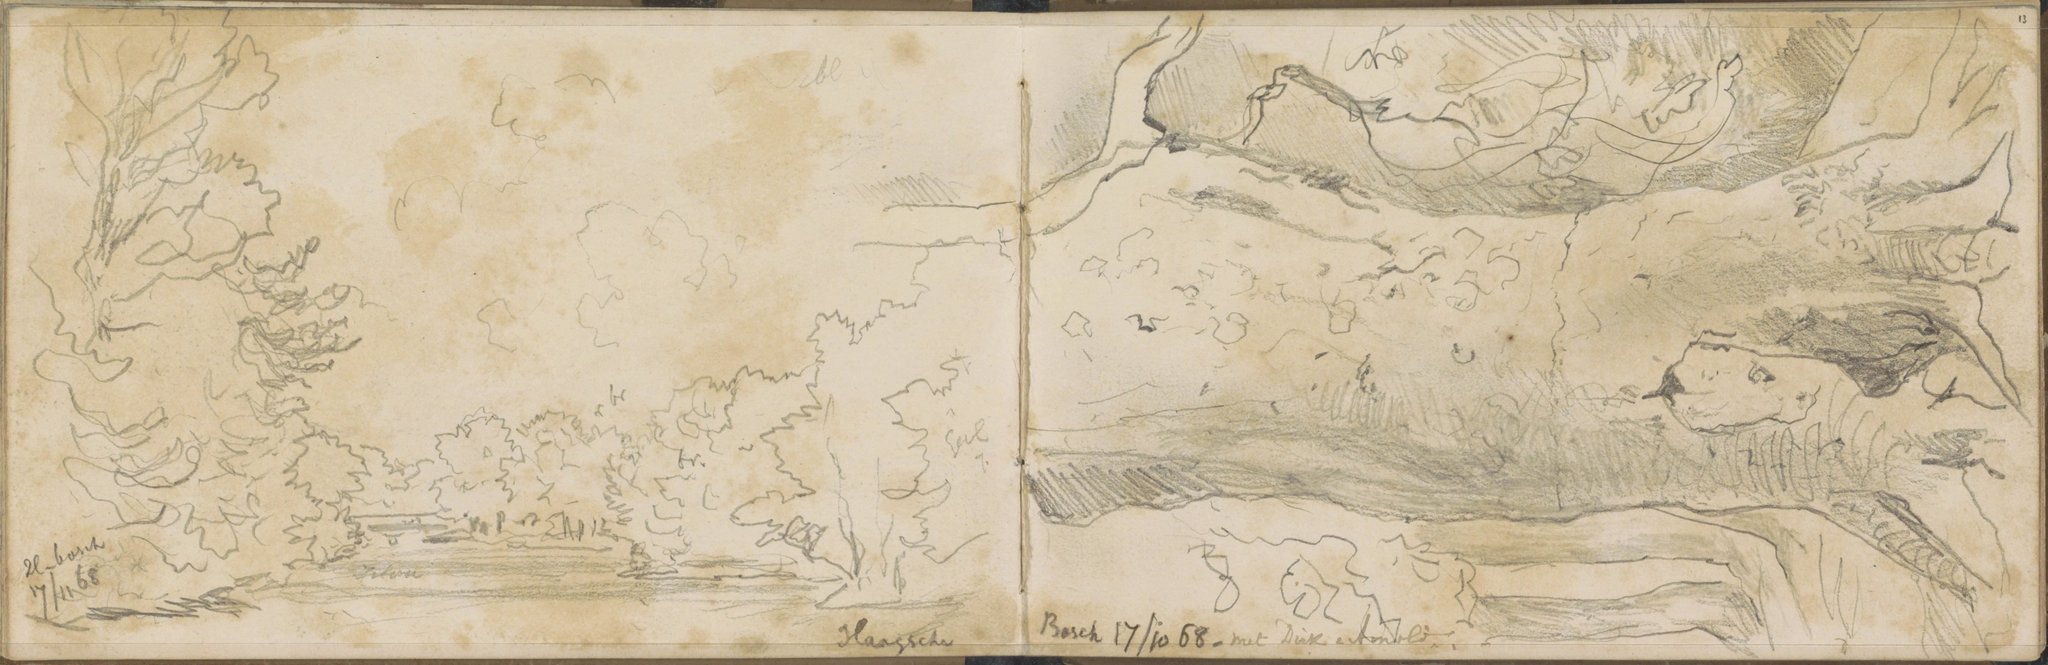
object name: sketchbook leaf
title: Haagse Bos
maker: johannes tavenraat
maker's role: draughtsman, painter, print maker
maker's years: 1809-1881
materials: paper, pencil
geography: the hague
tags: trees, forest, wood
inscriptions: date and inscription: ‘H. Bosch/ 17/11 68/ Haagsche Bosch 17/10 68. met Dirk & Arnold.’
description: Gezicht op het bos en een studie van een boomstam. Blad 12 verso en 13 recto uit een schetsboek met 48 bladen.